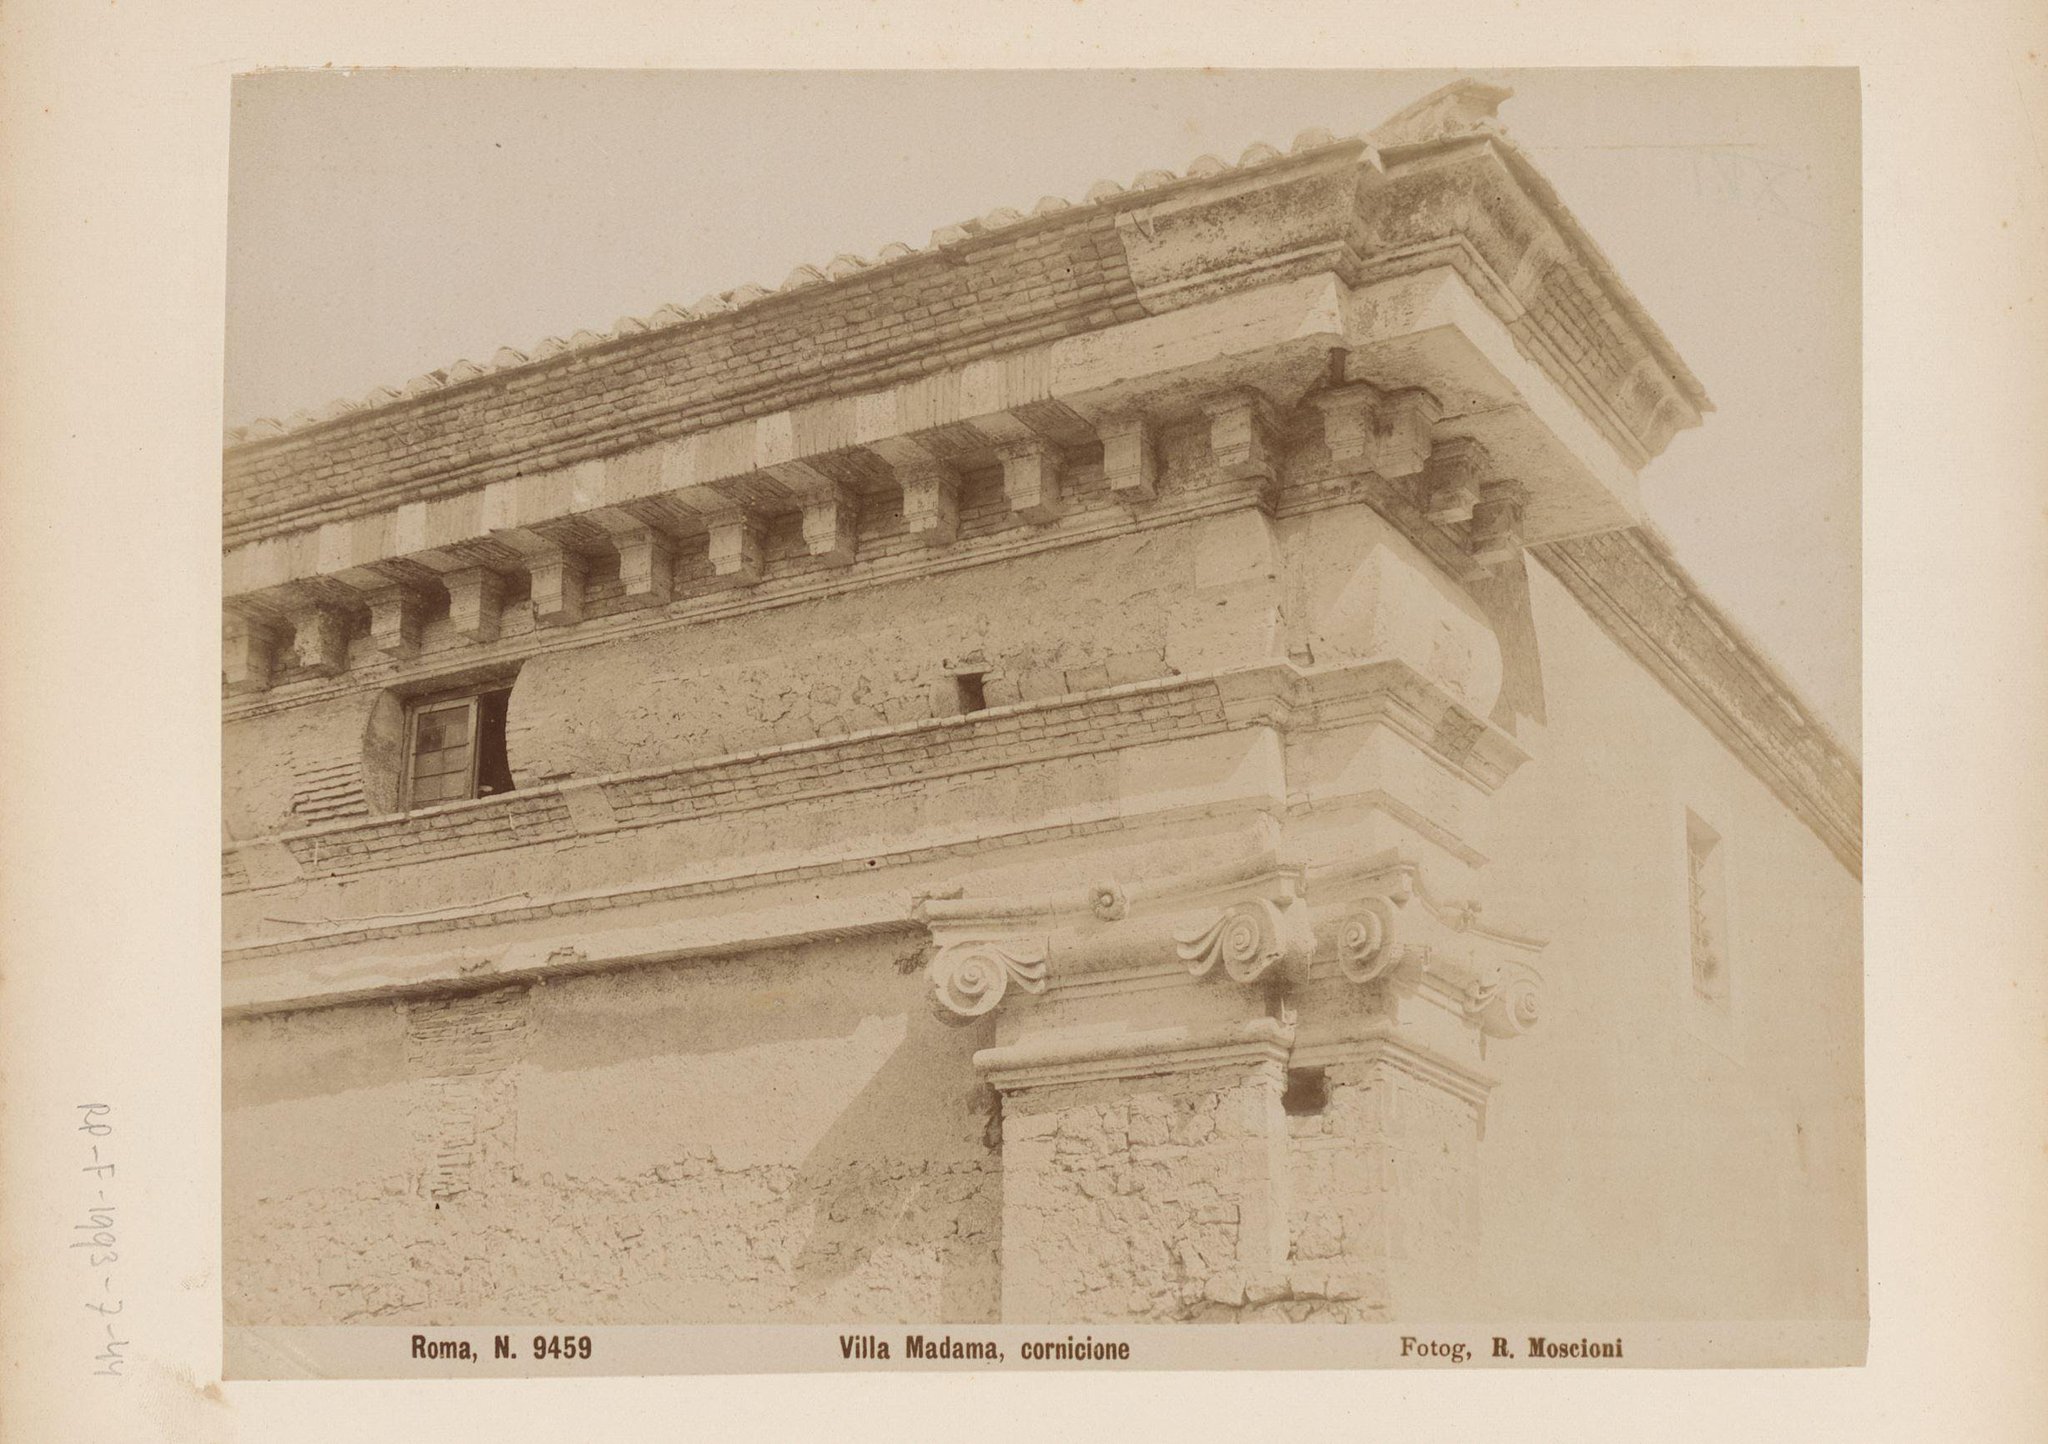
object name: photograph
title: Roma, N. 9459 Villa Madama, cornicione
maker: romualdo moscioni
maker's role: fotograaf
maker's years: 1849-1925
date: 1868-1900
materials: paper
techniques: albumen print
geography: villa madama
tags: villa, edge ~ stereometry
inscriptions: inscription: ‘Roma, N. 9459 Villa Madama, cornicione Fotog. R. Moscioni’